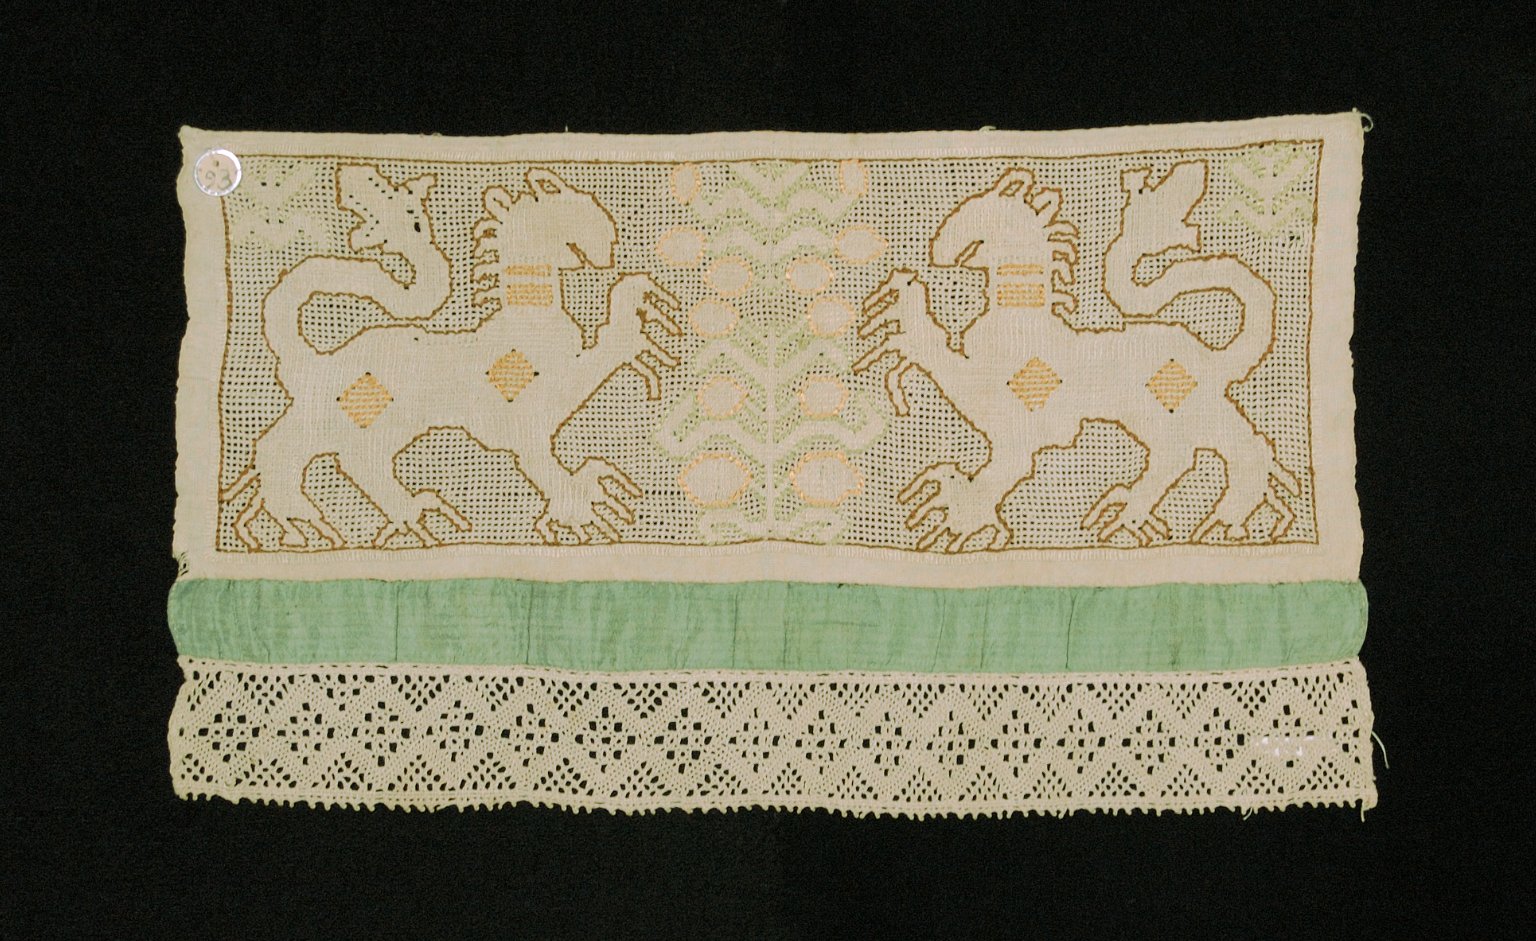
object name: border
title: Towel border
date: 1800-1850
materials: linen, silk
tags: animals